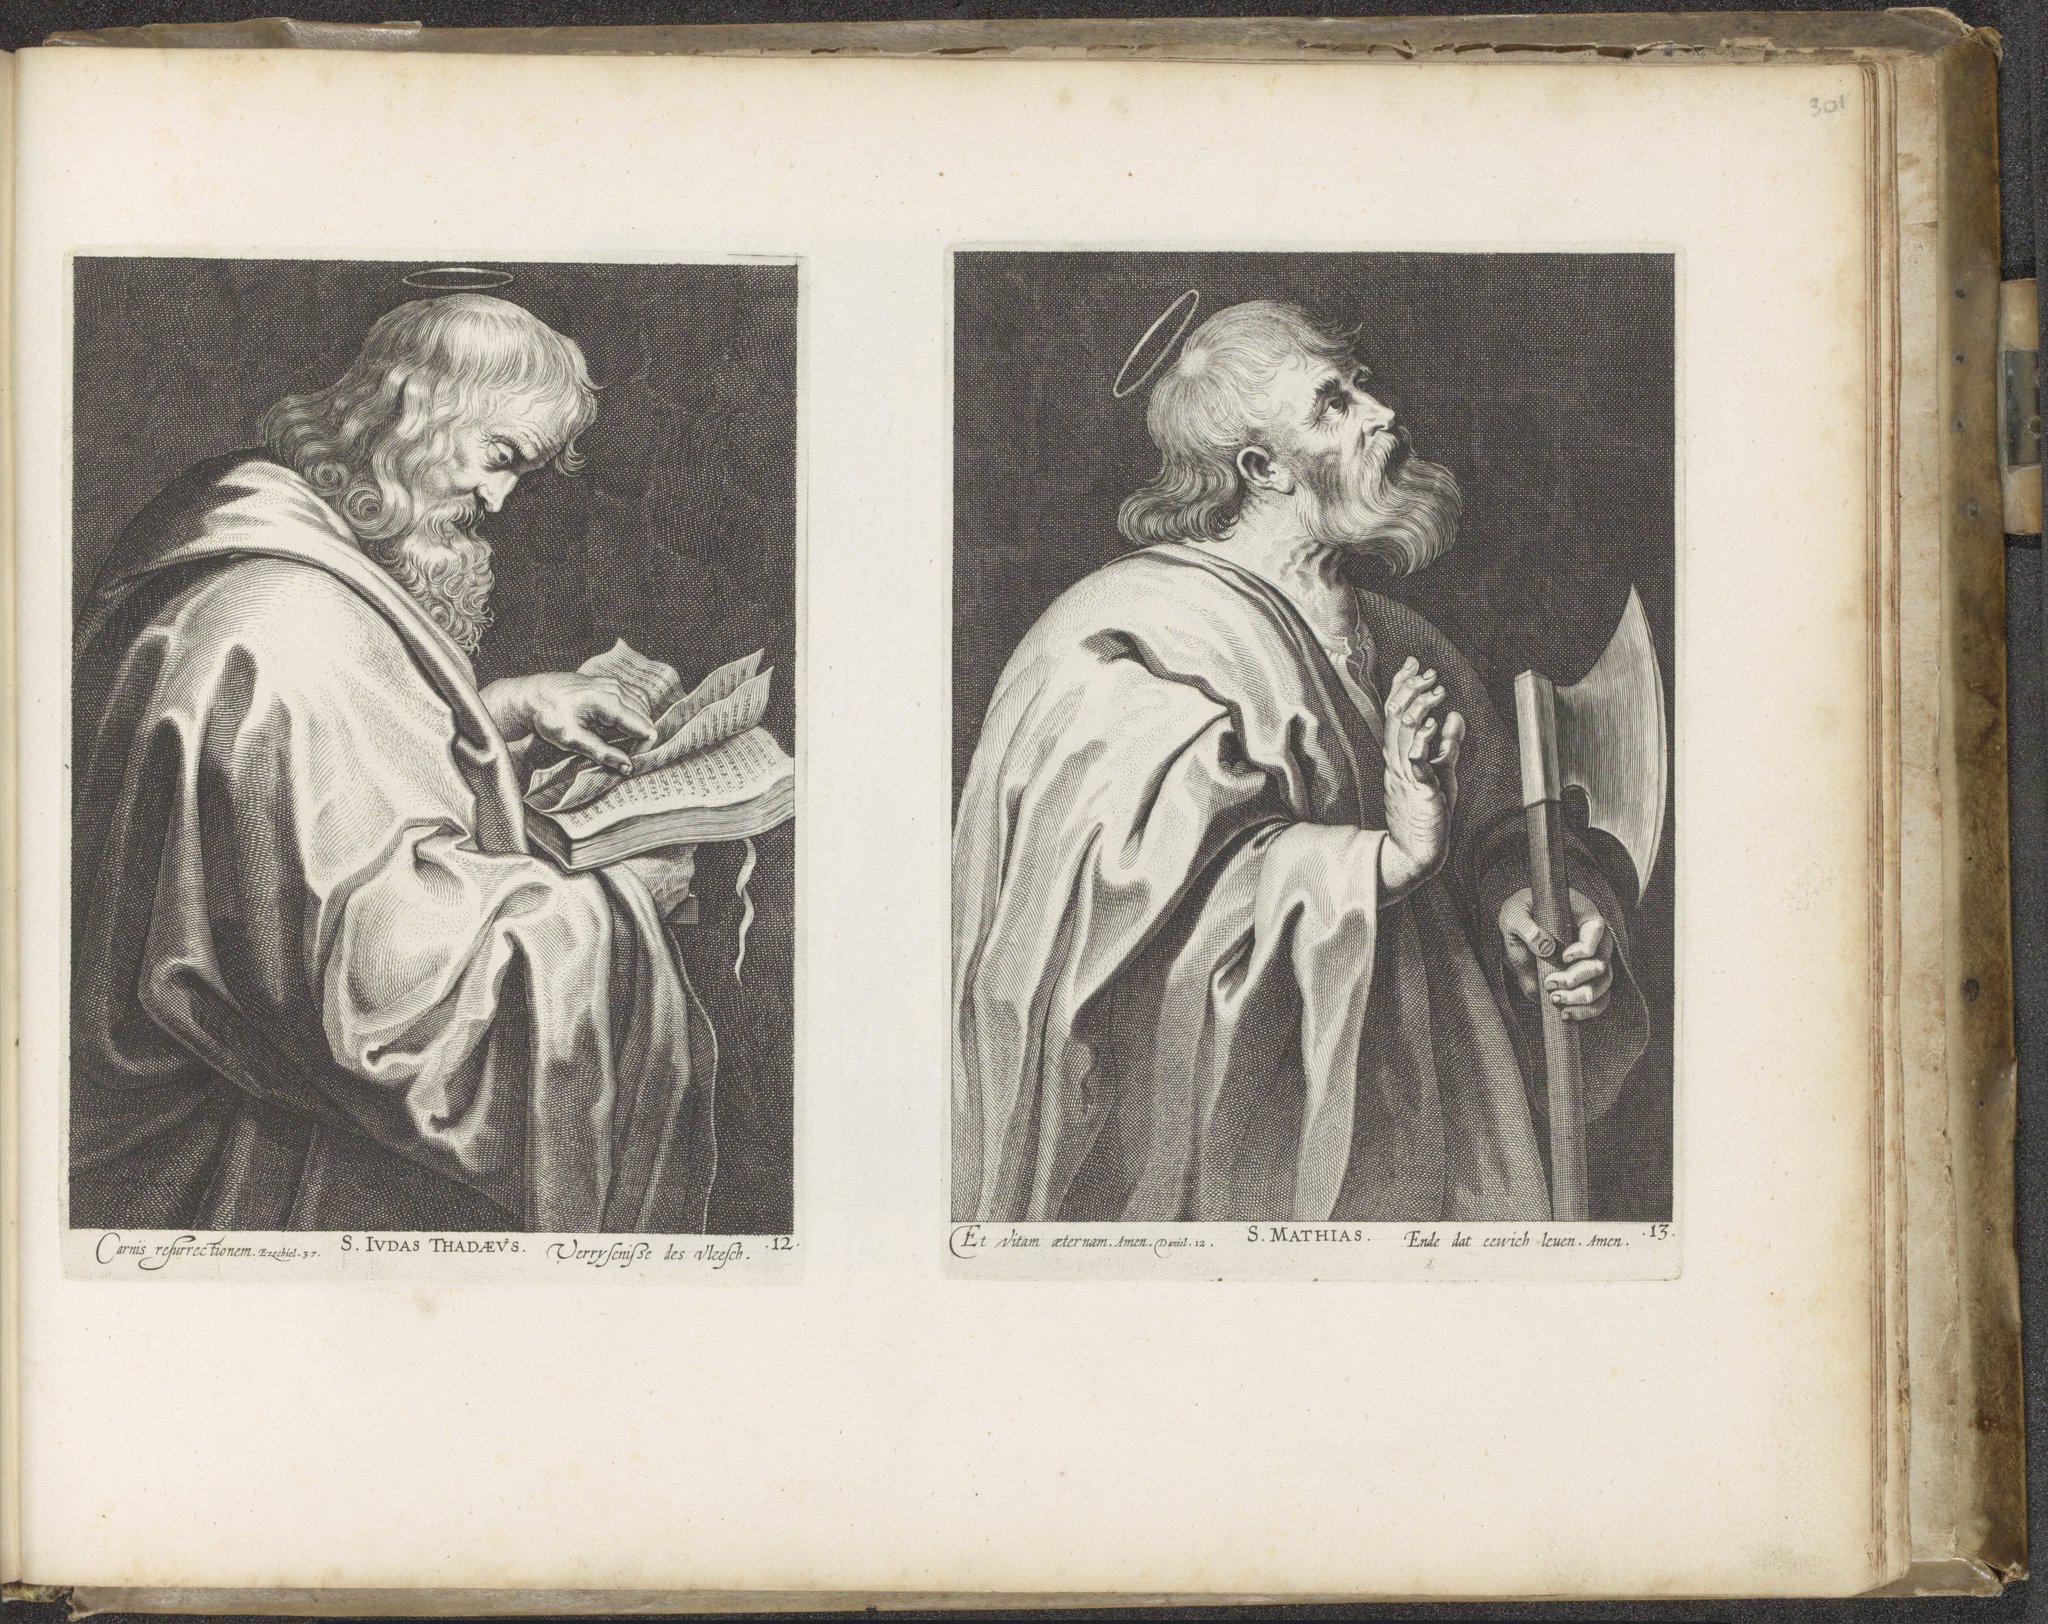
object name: print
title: Christus en dertien apostelen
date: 1616-1626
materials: paper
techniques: engraving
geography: amsterdam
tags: the apostle jude thaddaeus; possible attributes: book, club, halberd, scroll, the apostle and martyr matthias; possible attributes: axe, book, cross, halberd, scroll, sword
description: Twee voorstellingen op een albumblad. Links de apostel Judas Taddeüs bladerend in een boek. Rechts Mattias met bijl. In beide ondermarges een tweeregelige tekst in het Latijn en Nederlands. De prent maakt deel uit van een album.